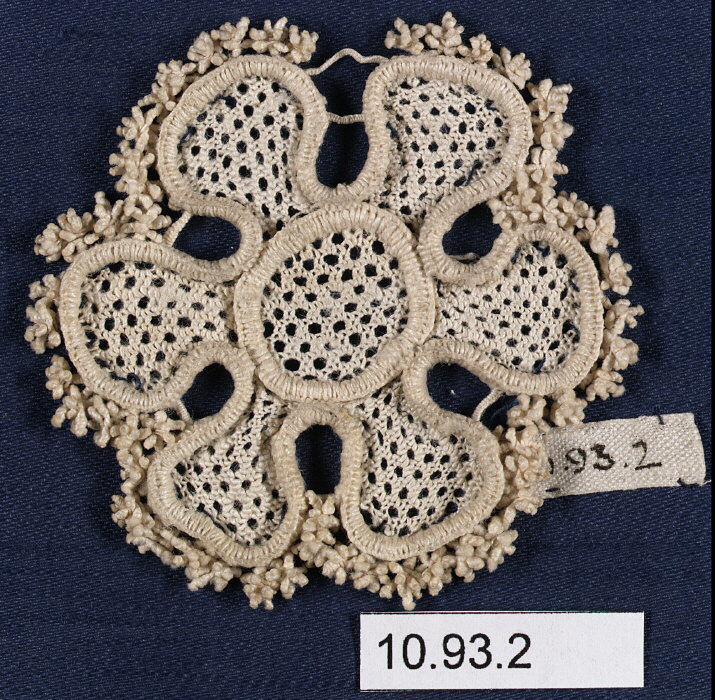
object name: rosace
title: Rosace (one of five)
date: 1701-1800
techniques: lace